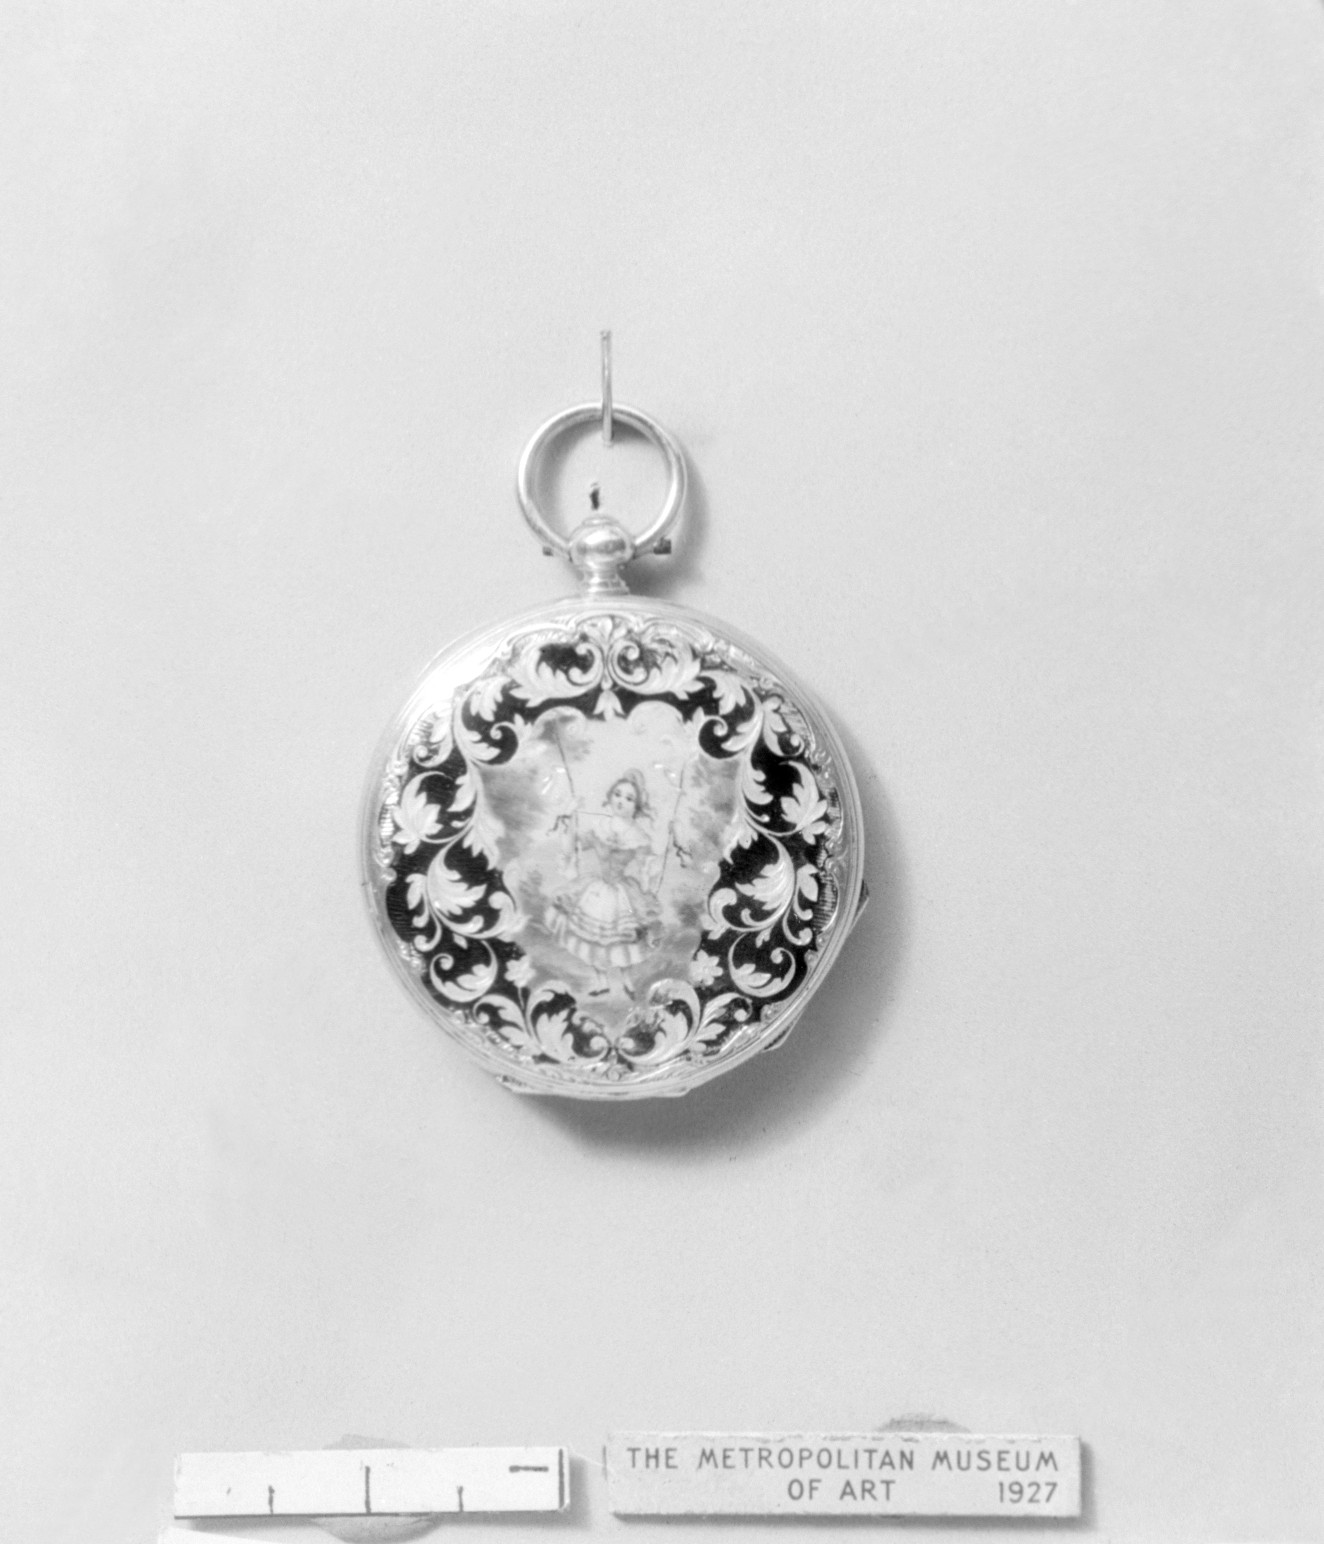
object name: watch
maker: patek & co.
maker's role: maker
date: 1845-1851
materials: enamel, gold, steel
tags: girls